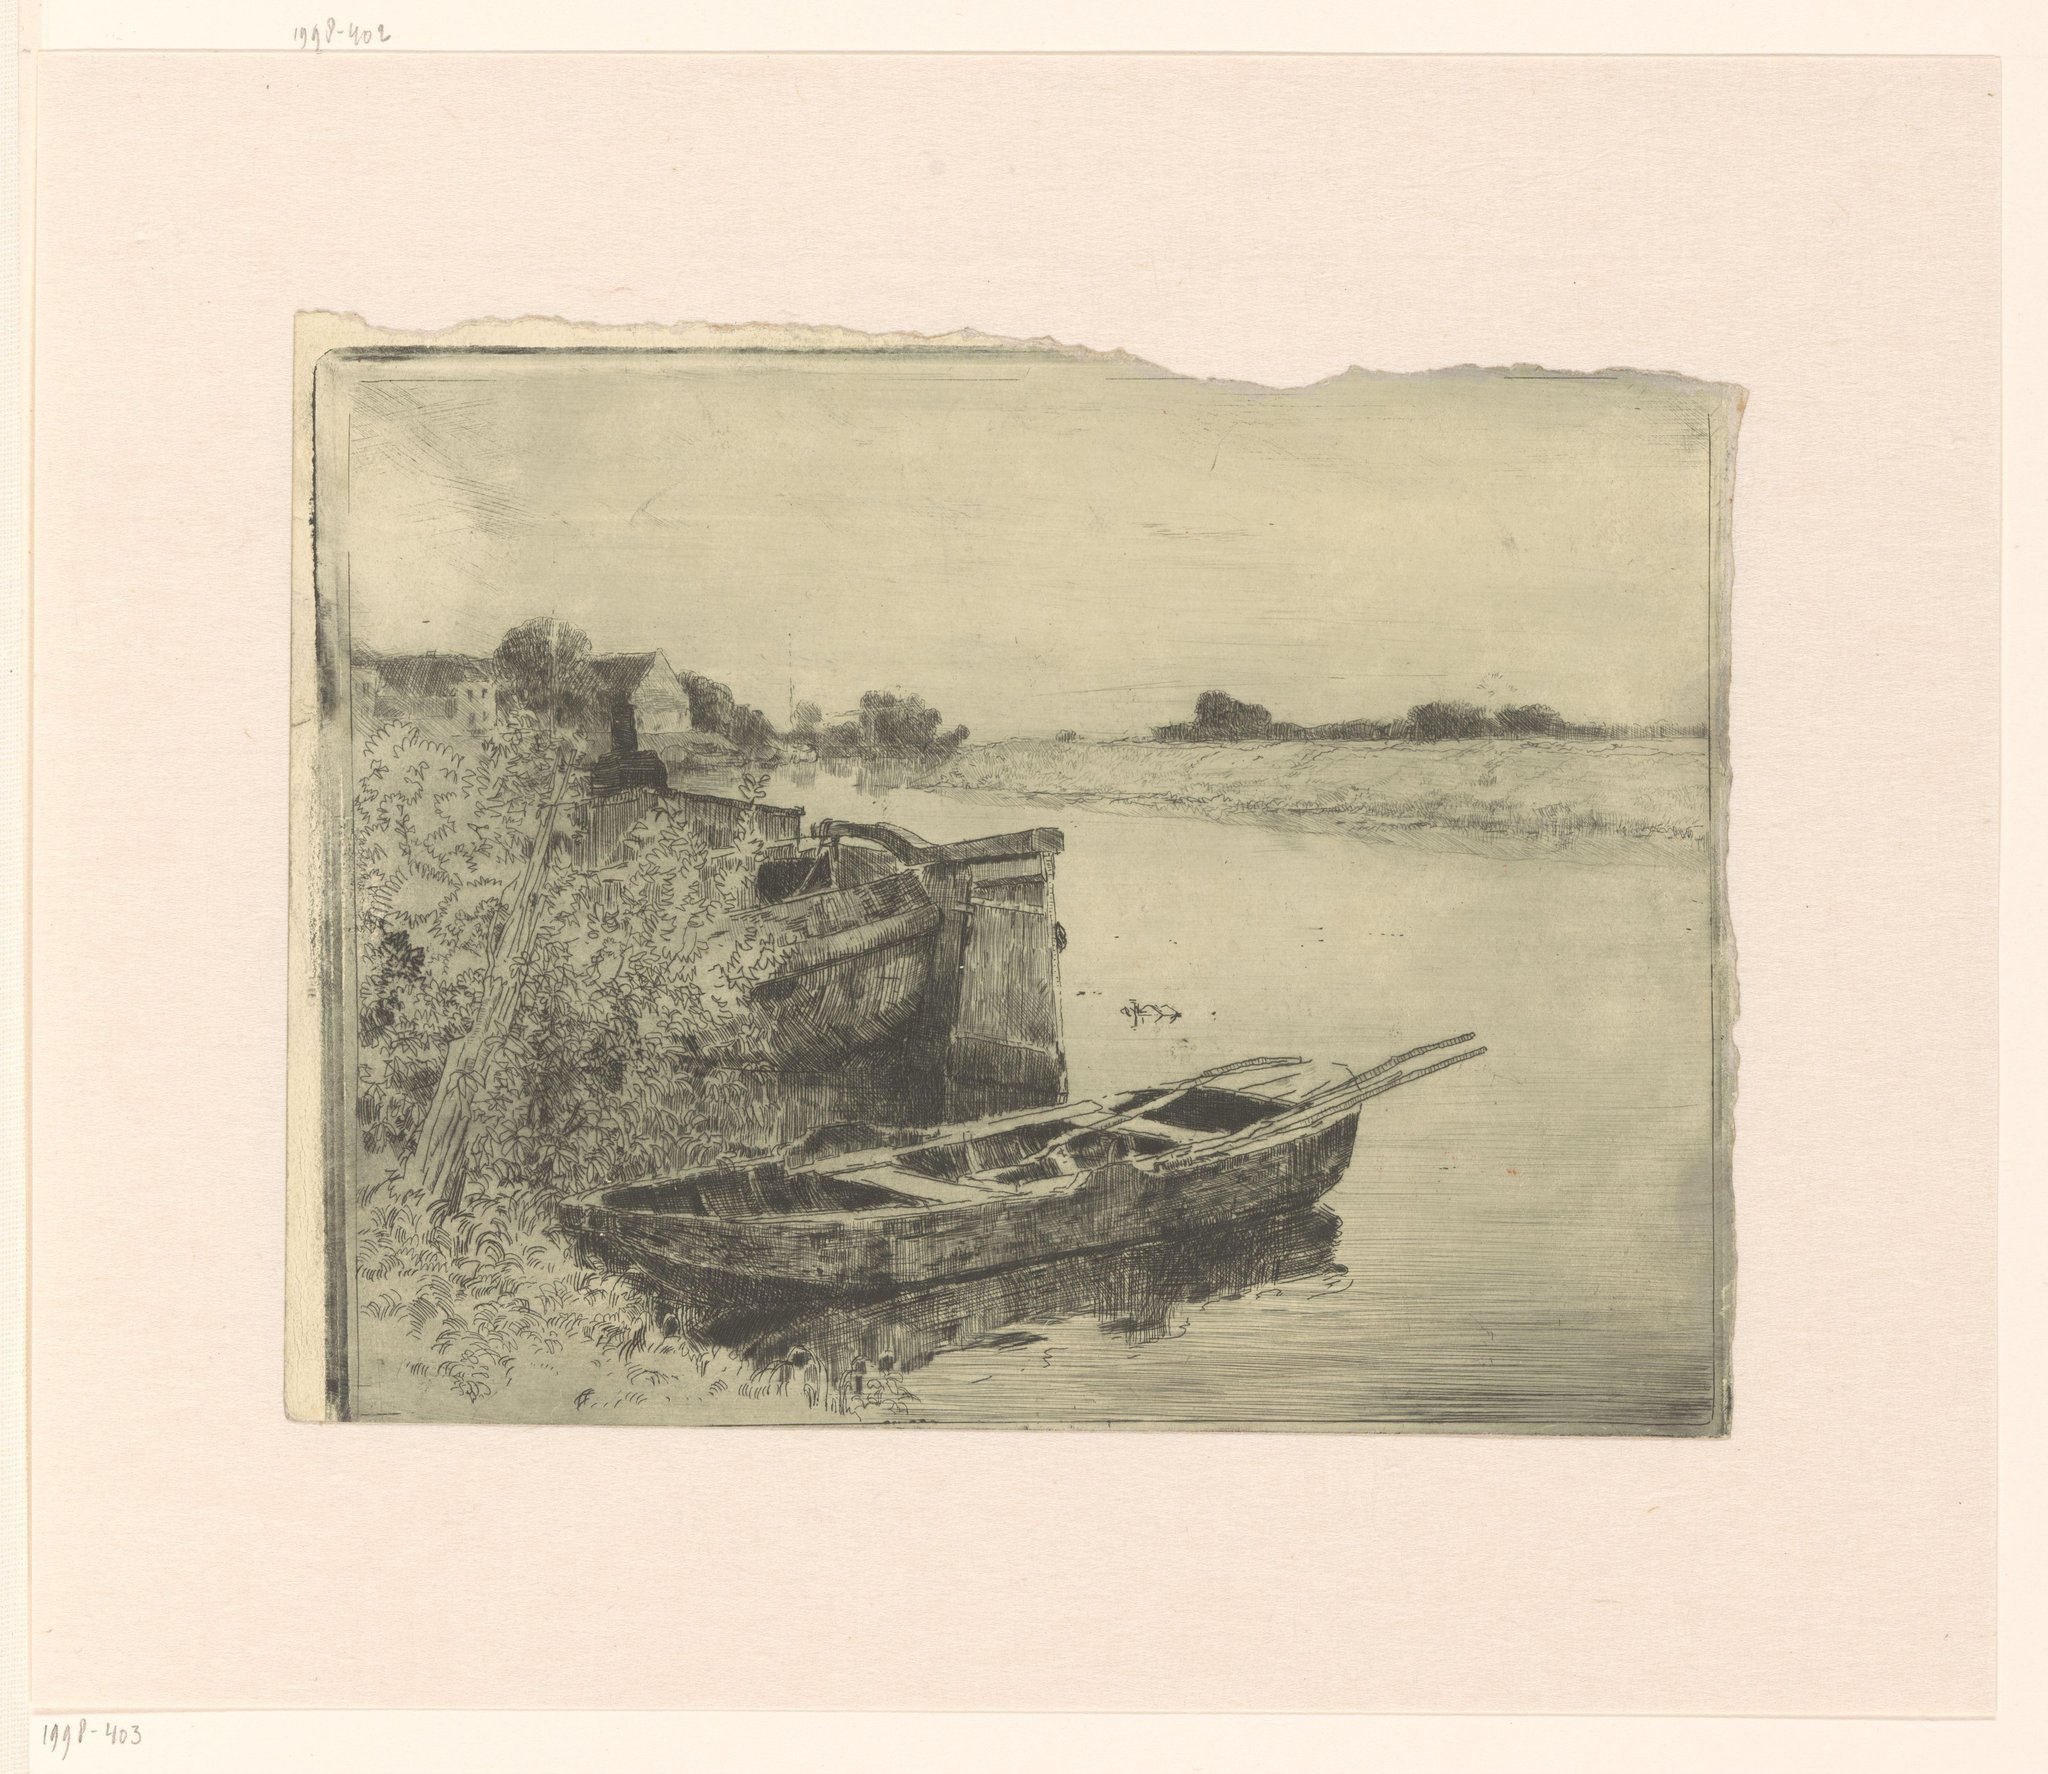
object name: print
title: Rivier met boten aan de waterkant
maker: cornelis vreedenburgh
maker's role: draughtsman, print maker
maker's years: 1880-1946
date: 1890-1946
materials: paper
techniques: etching, intaglio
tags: sailing-ship, sailing-boat, river, rowing-boat, canoe, etc.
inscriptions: collector's mark: Lugt 2760, collector's mark: Lugt 2228